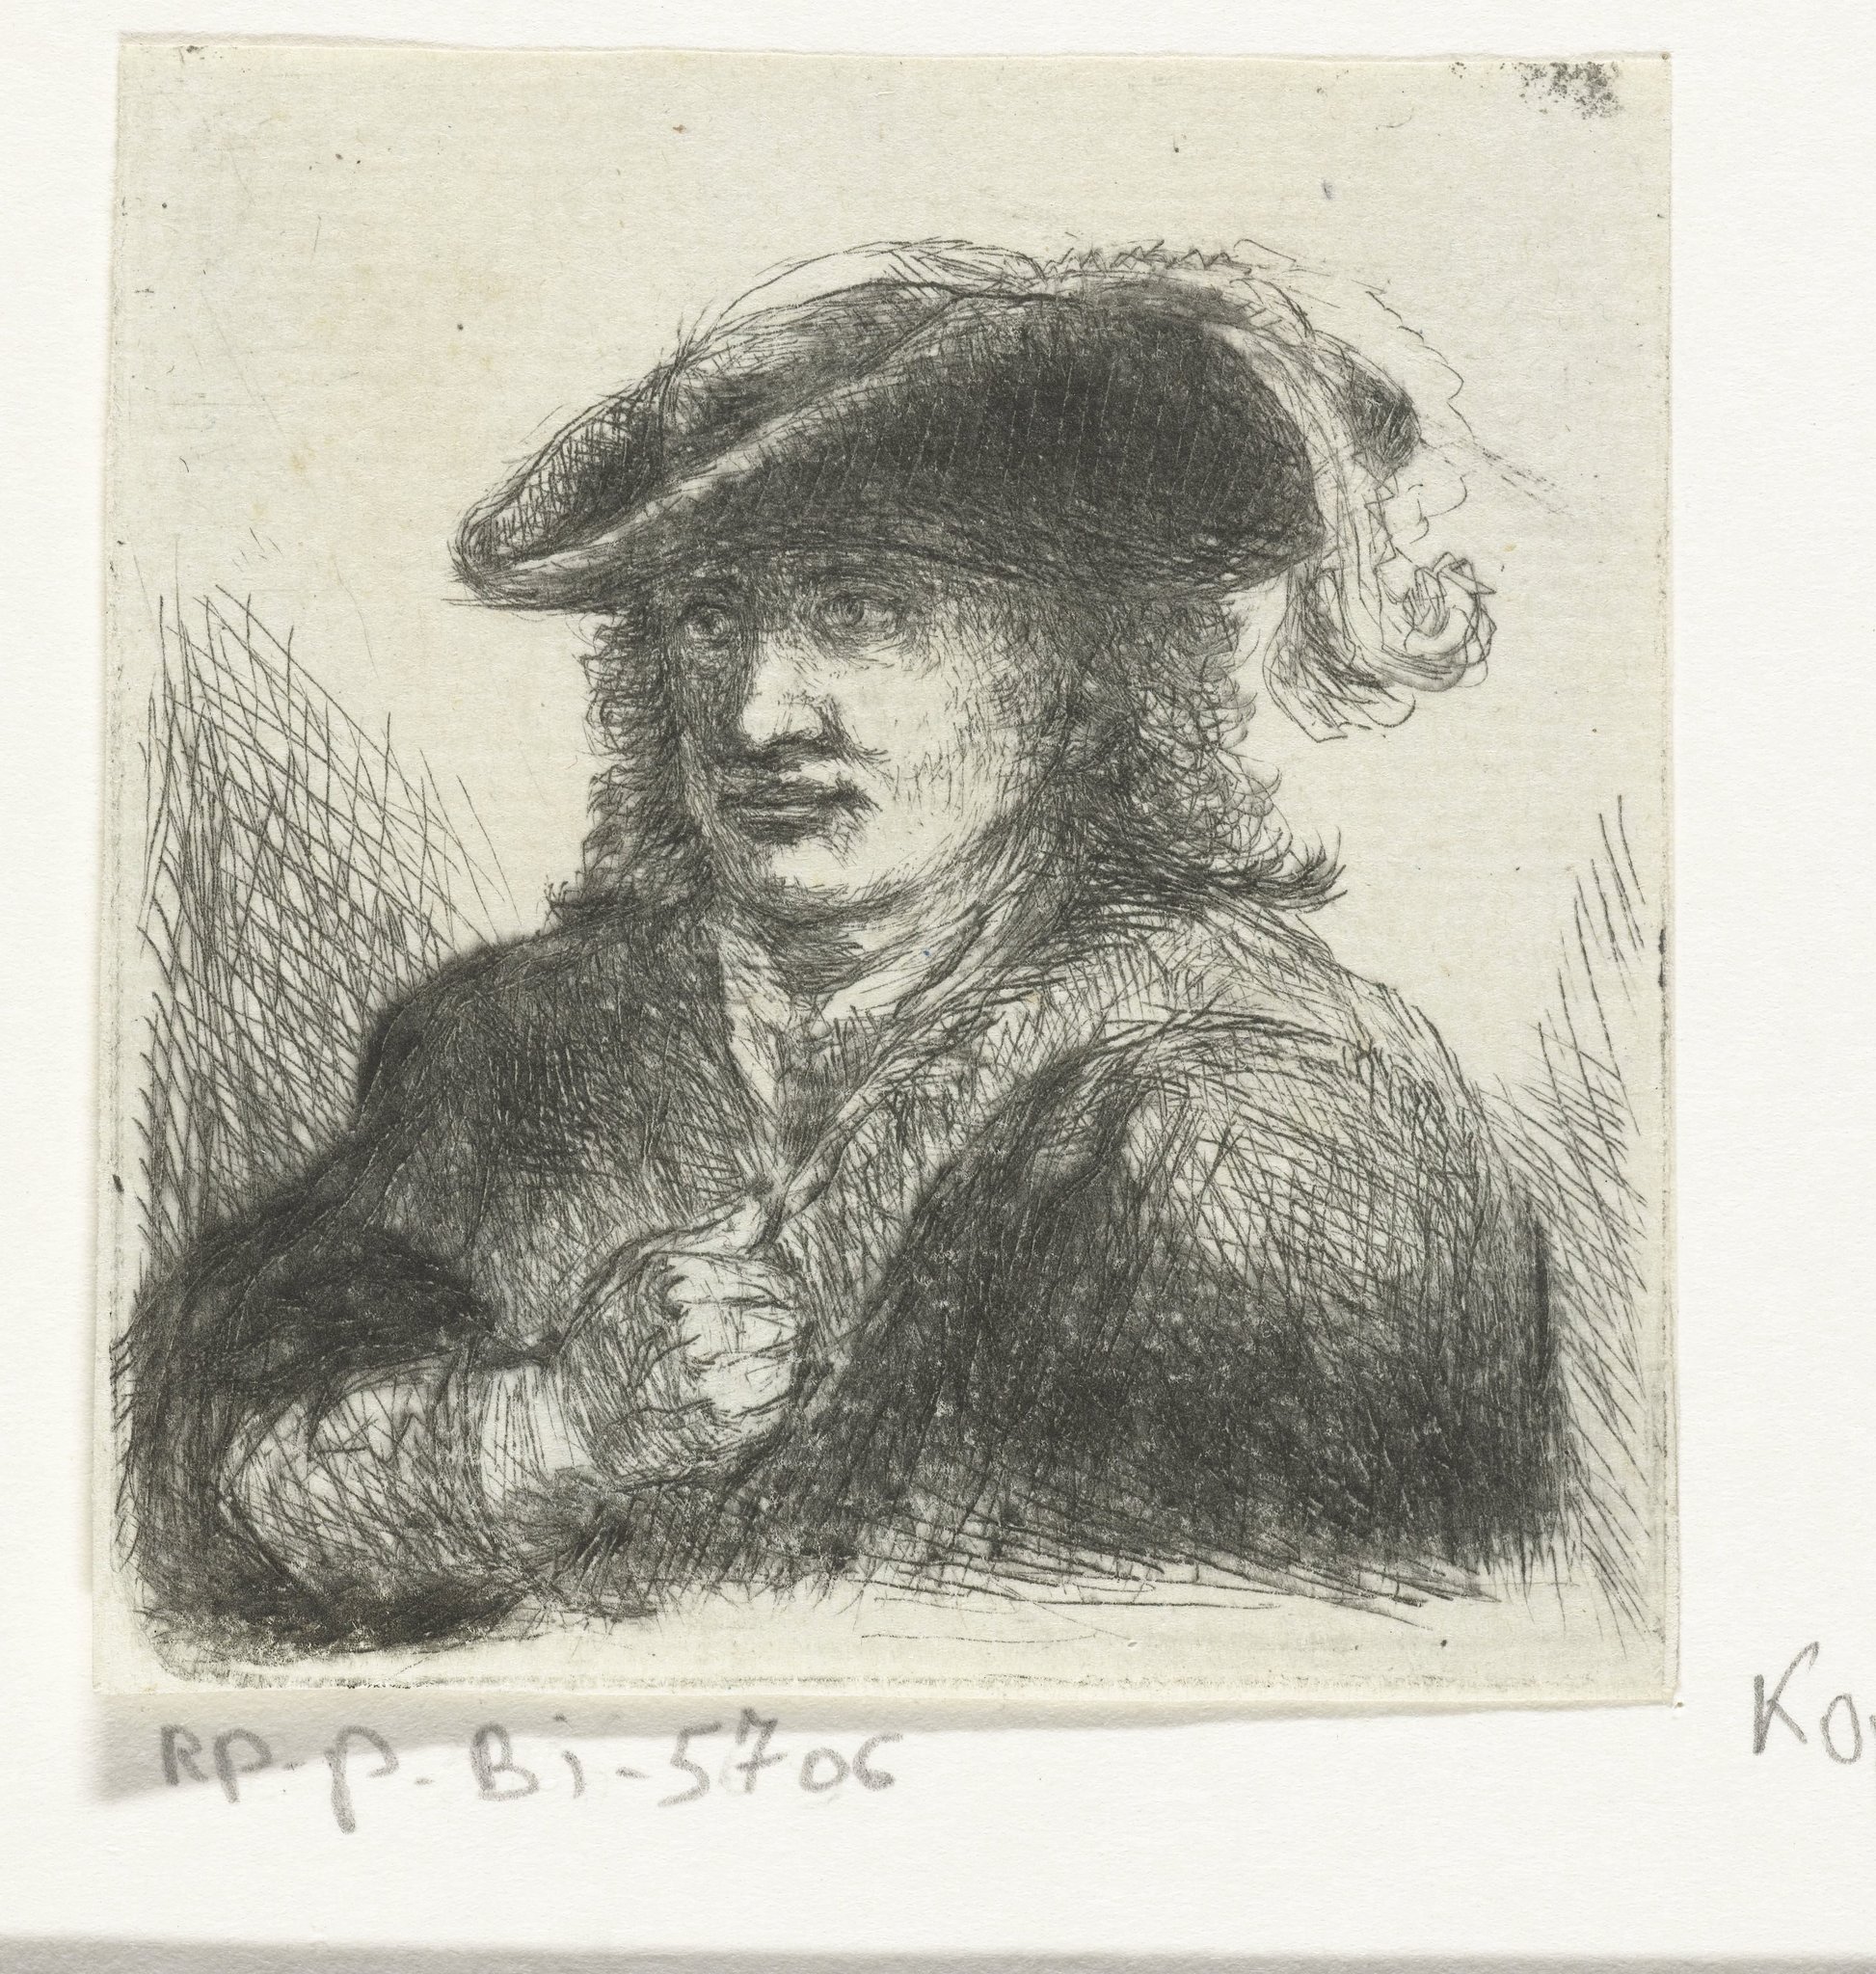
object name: print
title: Man met hoed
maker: jan chalon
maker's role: print maker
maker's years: 1738-1795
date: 1748-1795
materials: paper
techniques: drypoint, etching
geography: northern netherlands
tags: morphology of human expression (+ adult male (human being))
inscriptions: collector's mark: Lugt 2227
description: Een volwassen man met hoed en veer. Buste naar links.